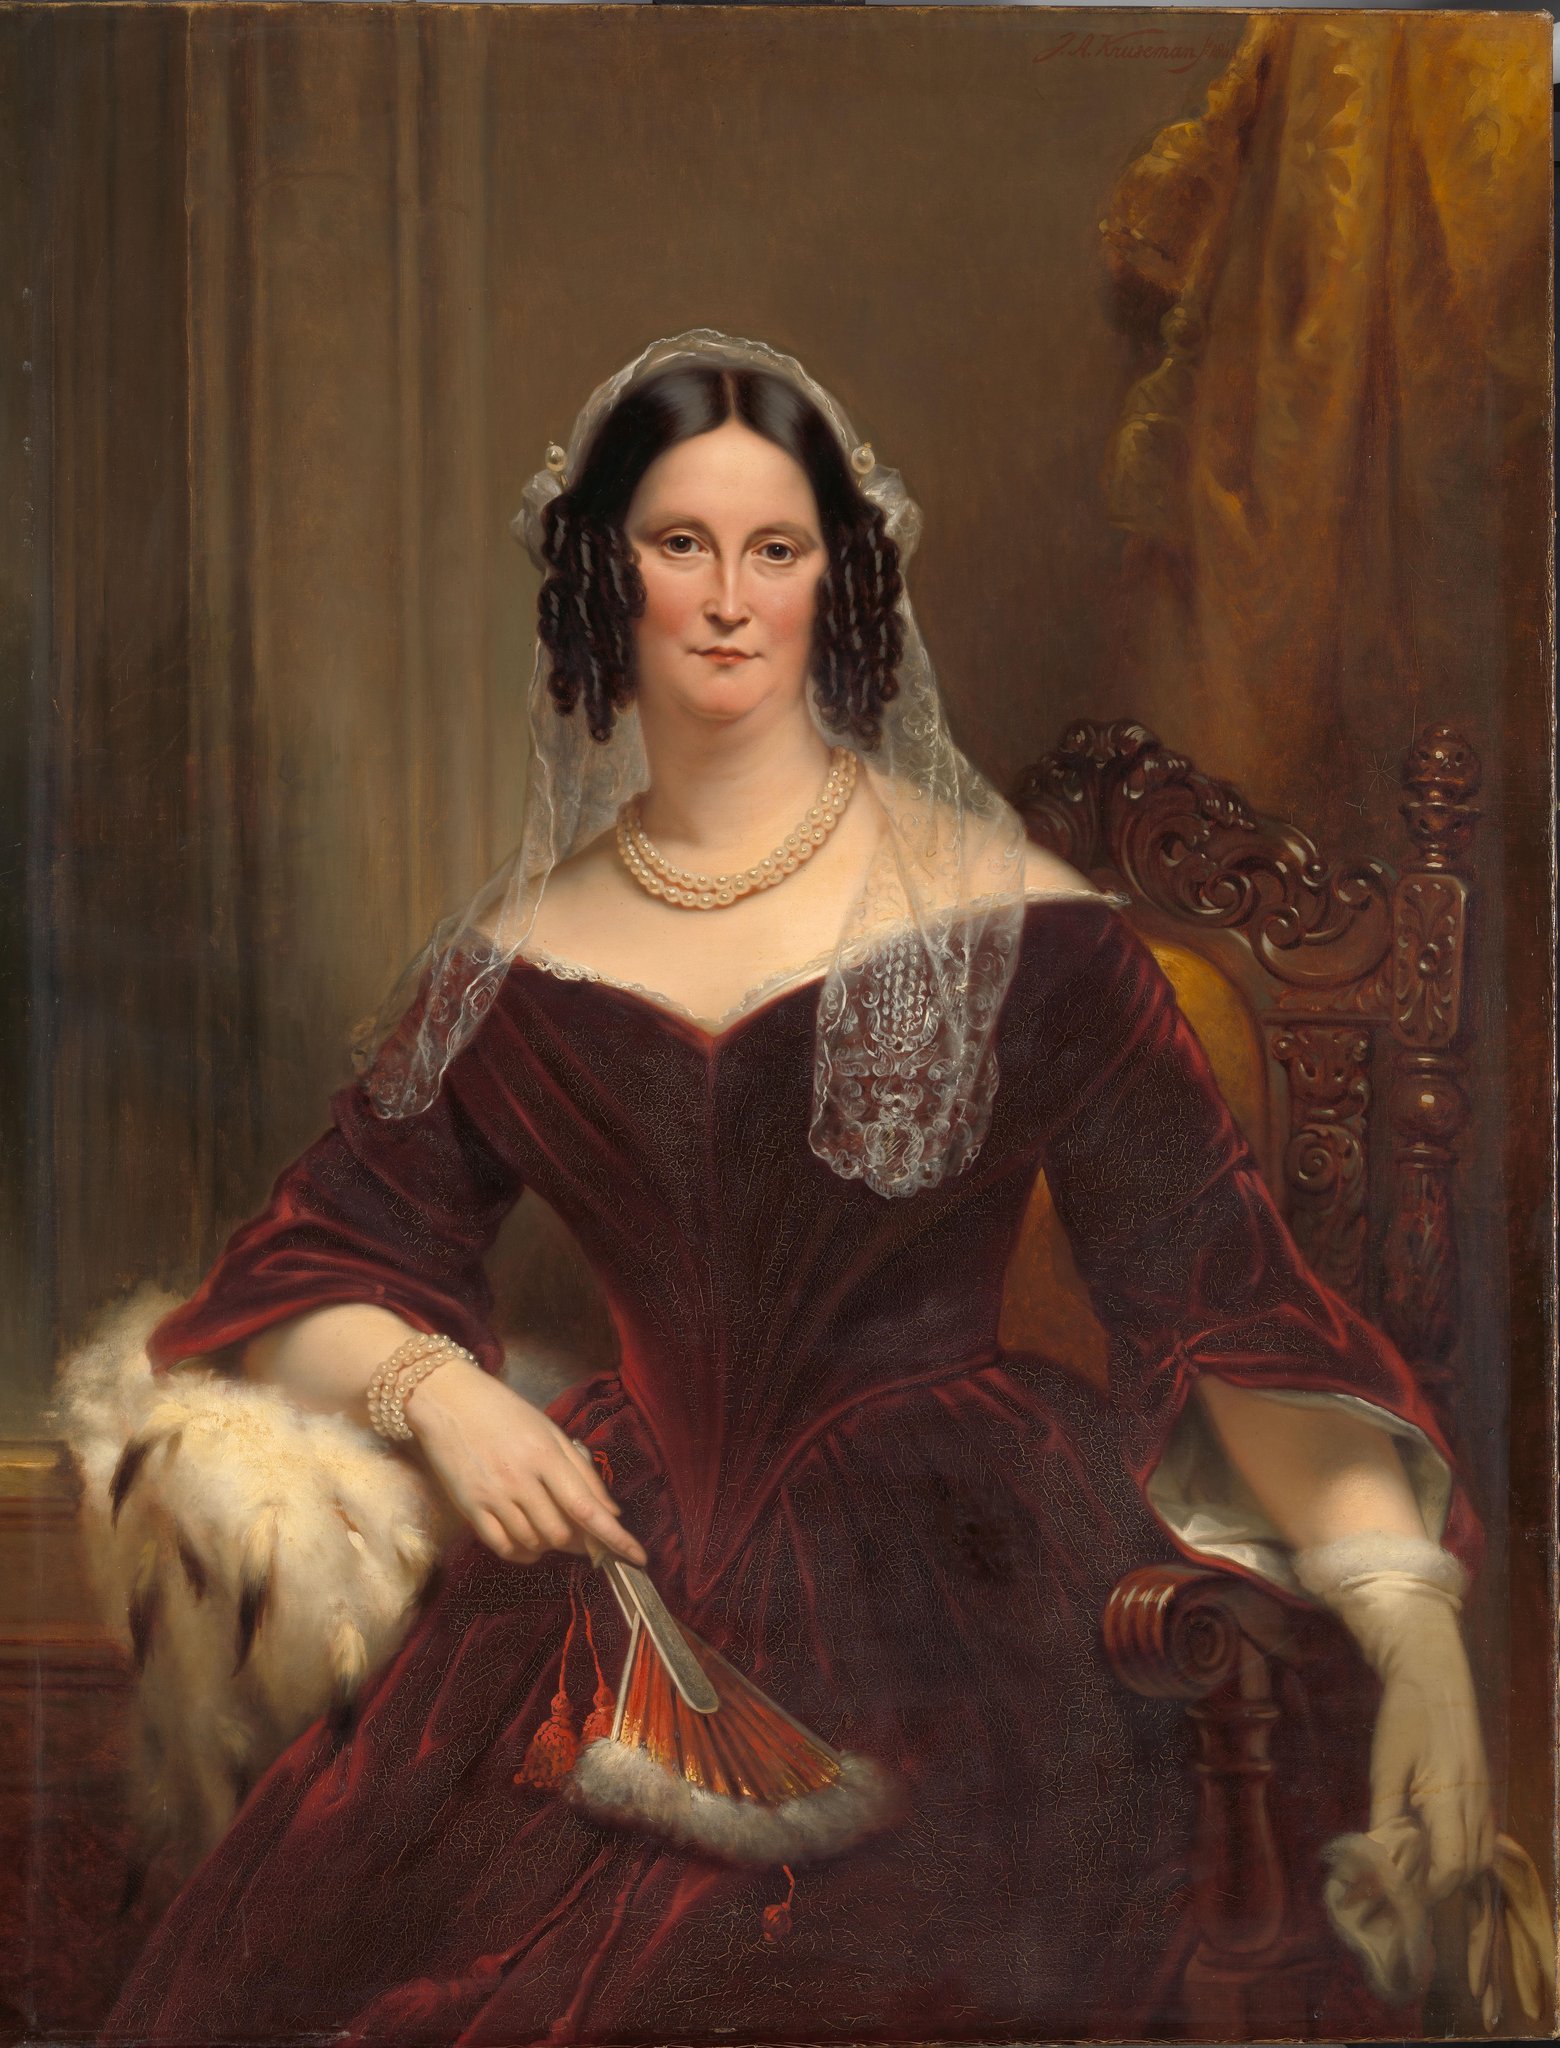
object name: painting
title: Dieuwke Fontein (1800-79), Second Wife (Married 1834) of Adriaan van der Hoop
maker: jan adam kruseman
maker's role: draughtsman, painter, print maker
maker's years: 1804-1862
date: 1844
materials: canvas, oil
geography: netherlands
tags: harlingen, historical persons - bb - woman, fan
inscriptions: signature and date: ‘J.A. Kruseman f 1844’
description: Portret van Dieuwke Fontein, sinds 1834 de tweede echtgenote van Adriaan van der Hoop. Kniestuk, zittend in een stoel, een waaier in de rechterhand, handschoen in de linker. Pendant van SK-C-169.